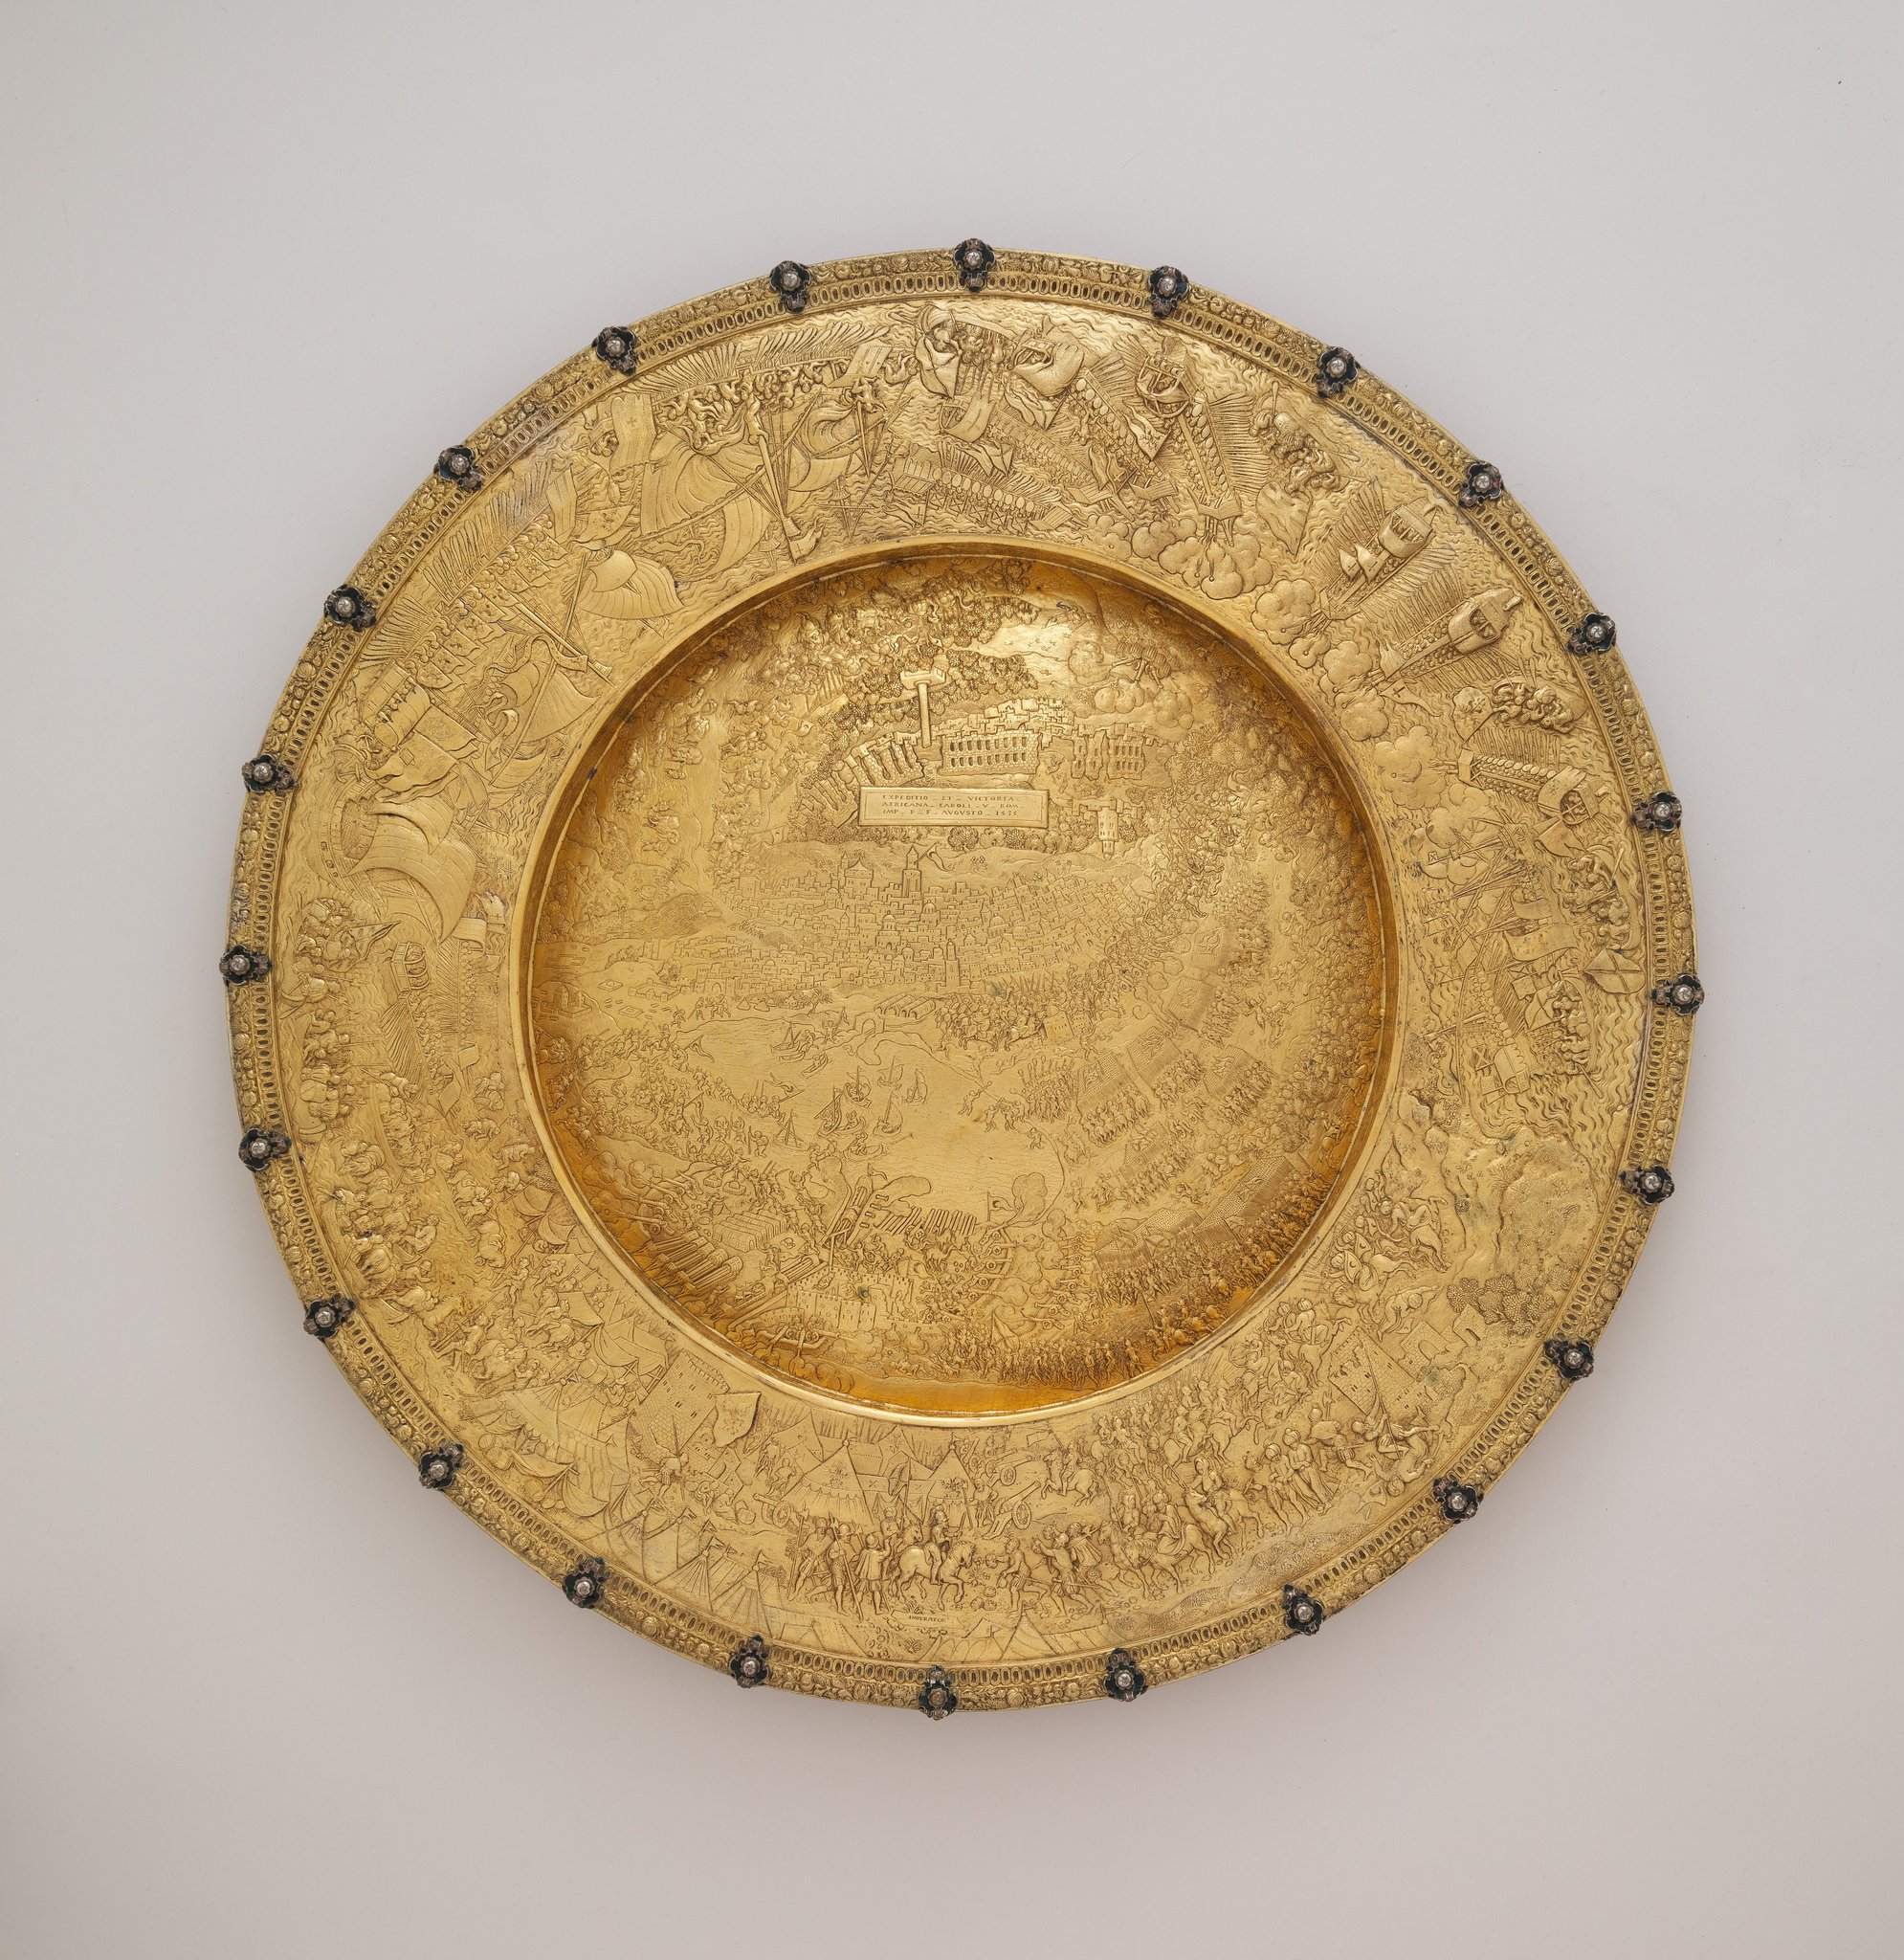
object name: salver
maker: franchi and son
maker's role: maker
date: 1801-1900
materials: metal, silver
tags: battles,horses,boats